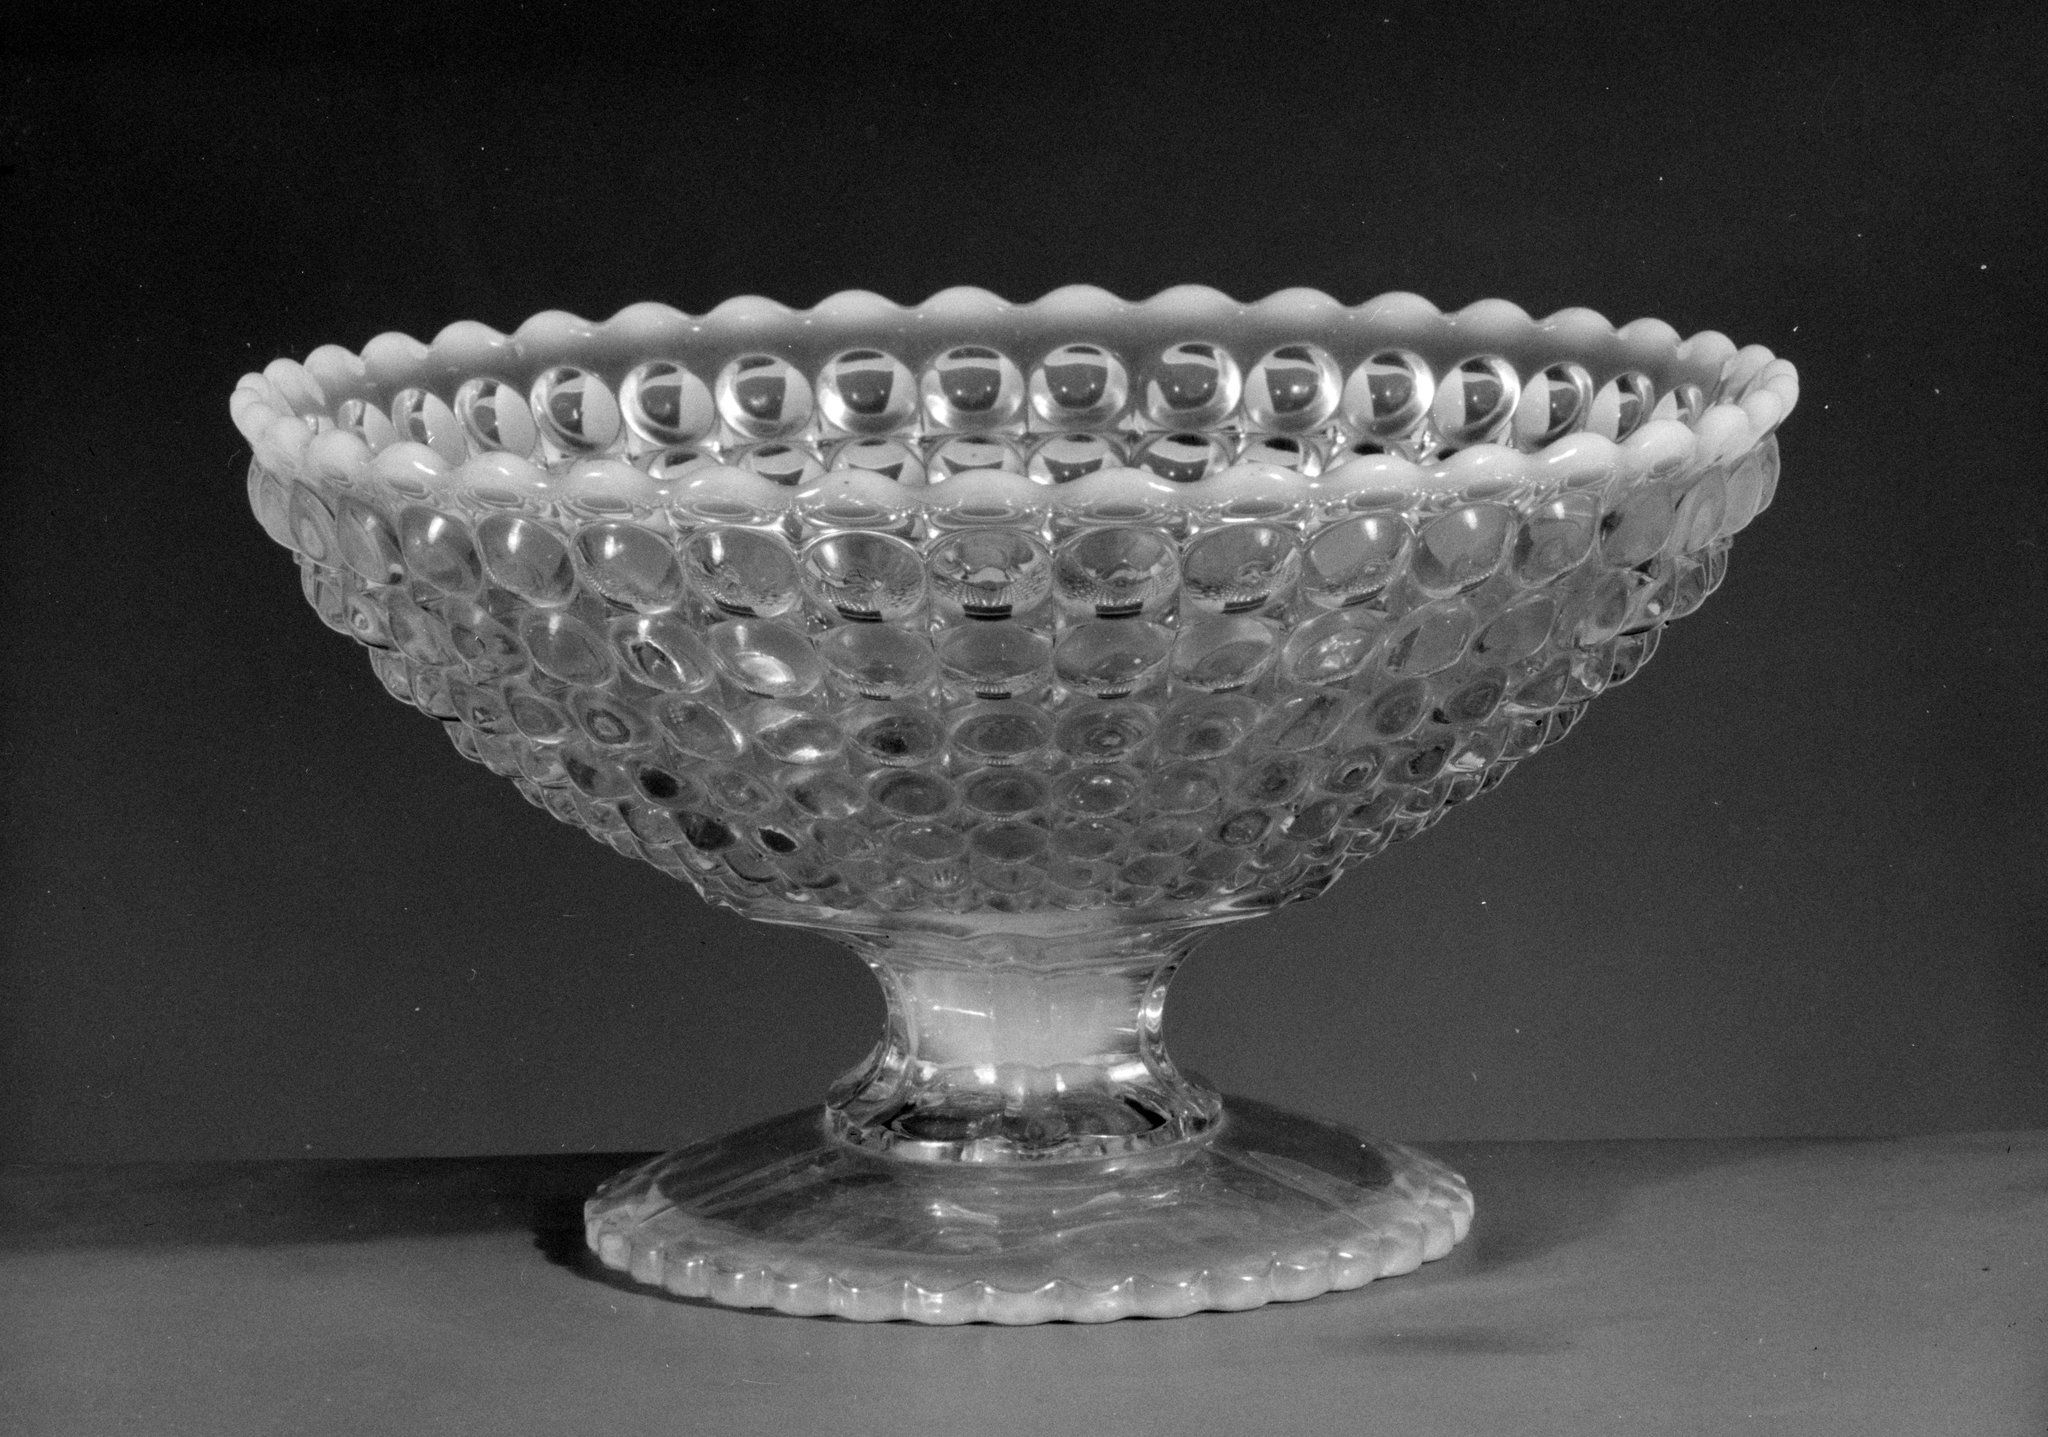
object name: compote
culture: american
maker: richards and hartley flint glass co.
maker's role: maker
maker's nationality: american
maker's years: 1867-1890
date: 1888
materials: glass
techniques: pressed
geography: united states